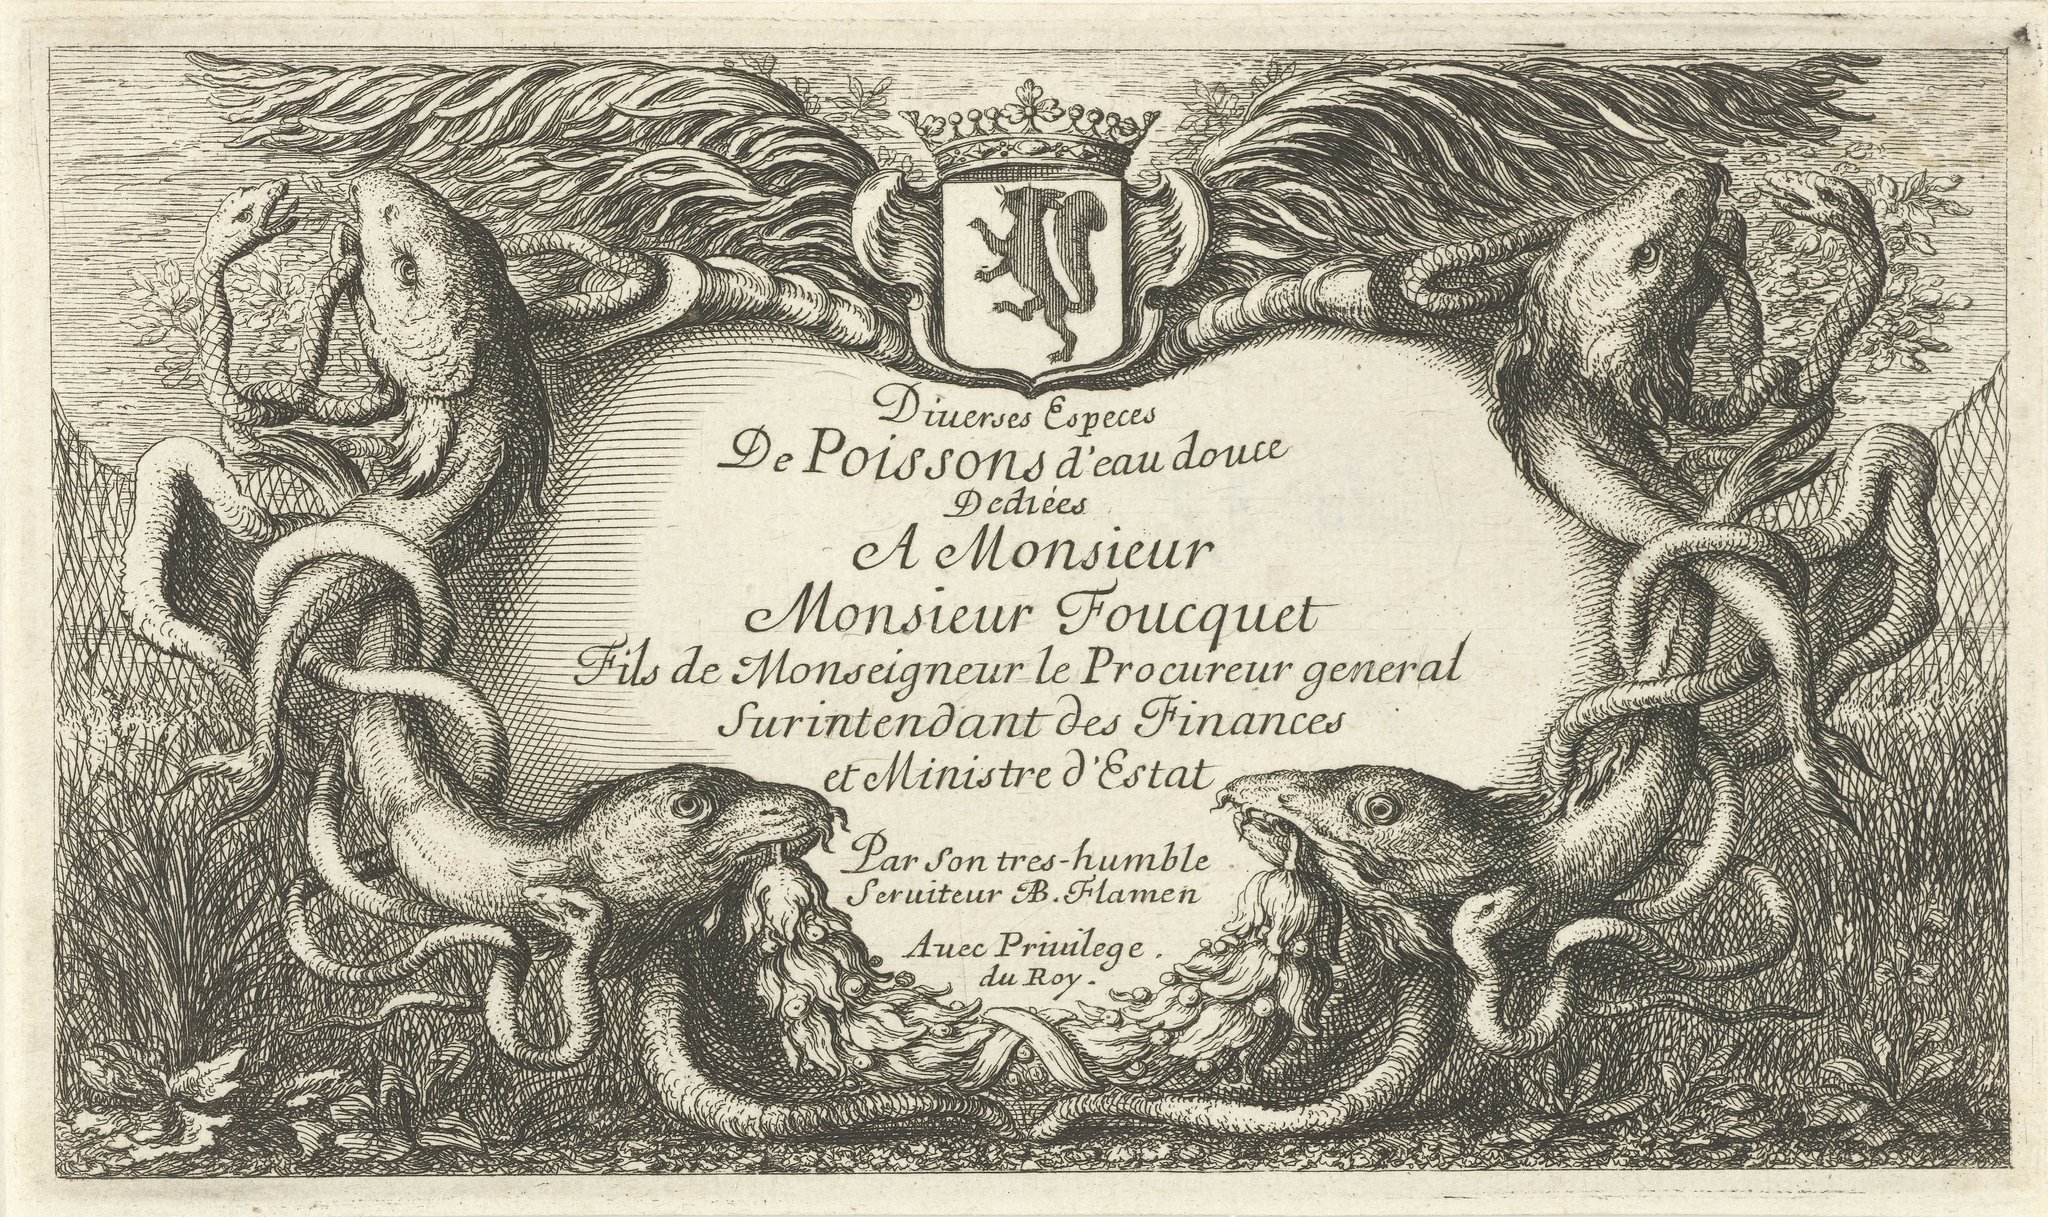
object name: print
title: Diverses Especes de Poissons d'eau douce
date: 1664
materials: paper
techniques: etching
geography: france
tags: fishes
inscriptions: collector's mark: Lugt 2228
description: Cartouche met een rand van vissen en waterslangen. In het cartouche Franse tekst met serietitel en vervaardigersnamen. Bovenaan het wapen van Nicolas Foucquet. Titelprent voor de eerste zoetwater reeks van vijf reeksen met verschillende vissoorten en andere zeedieren.